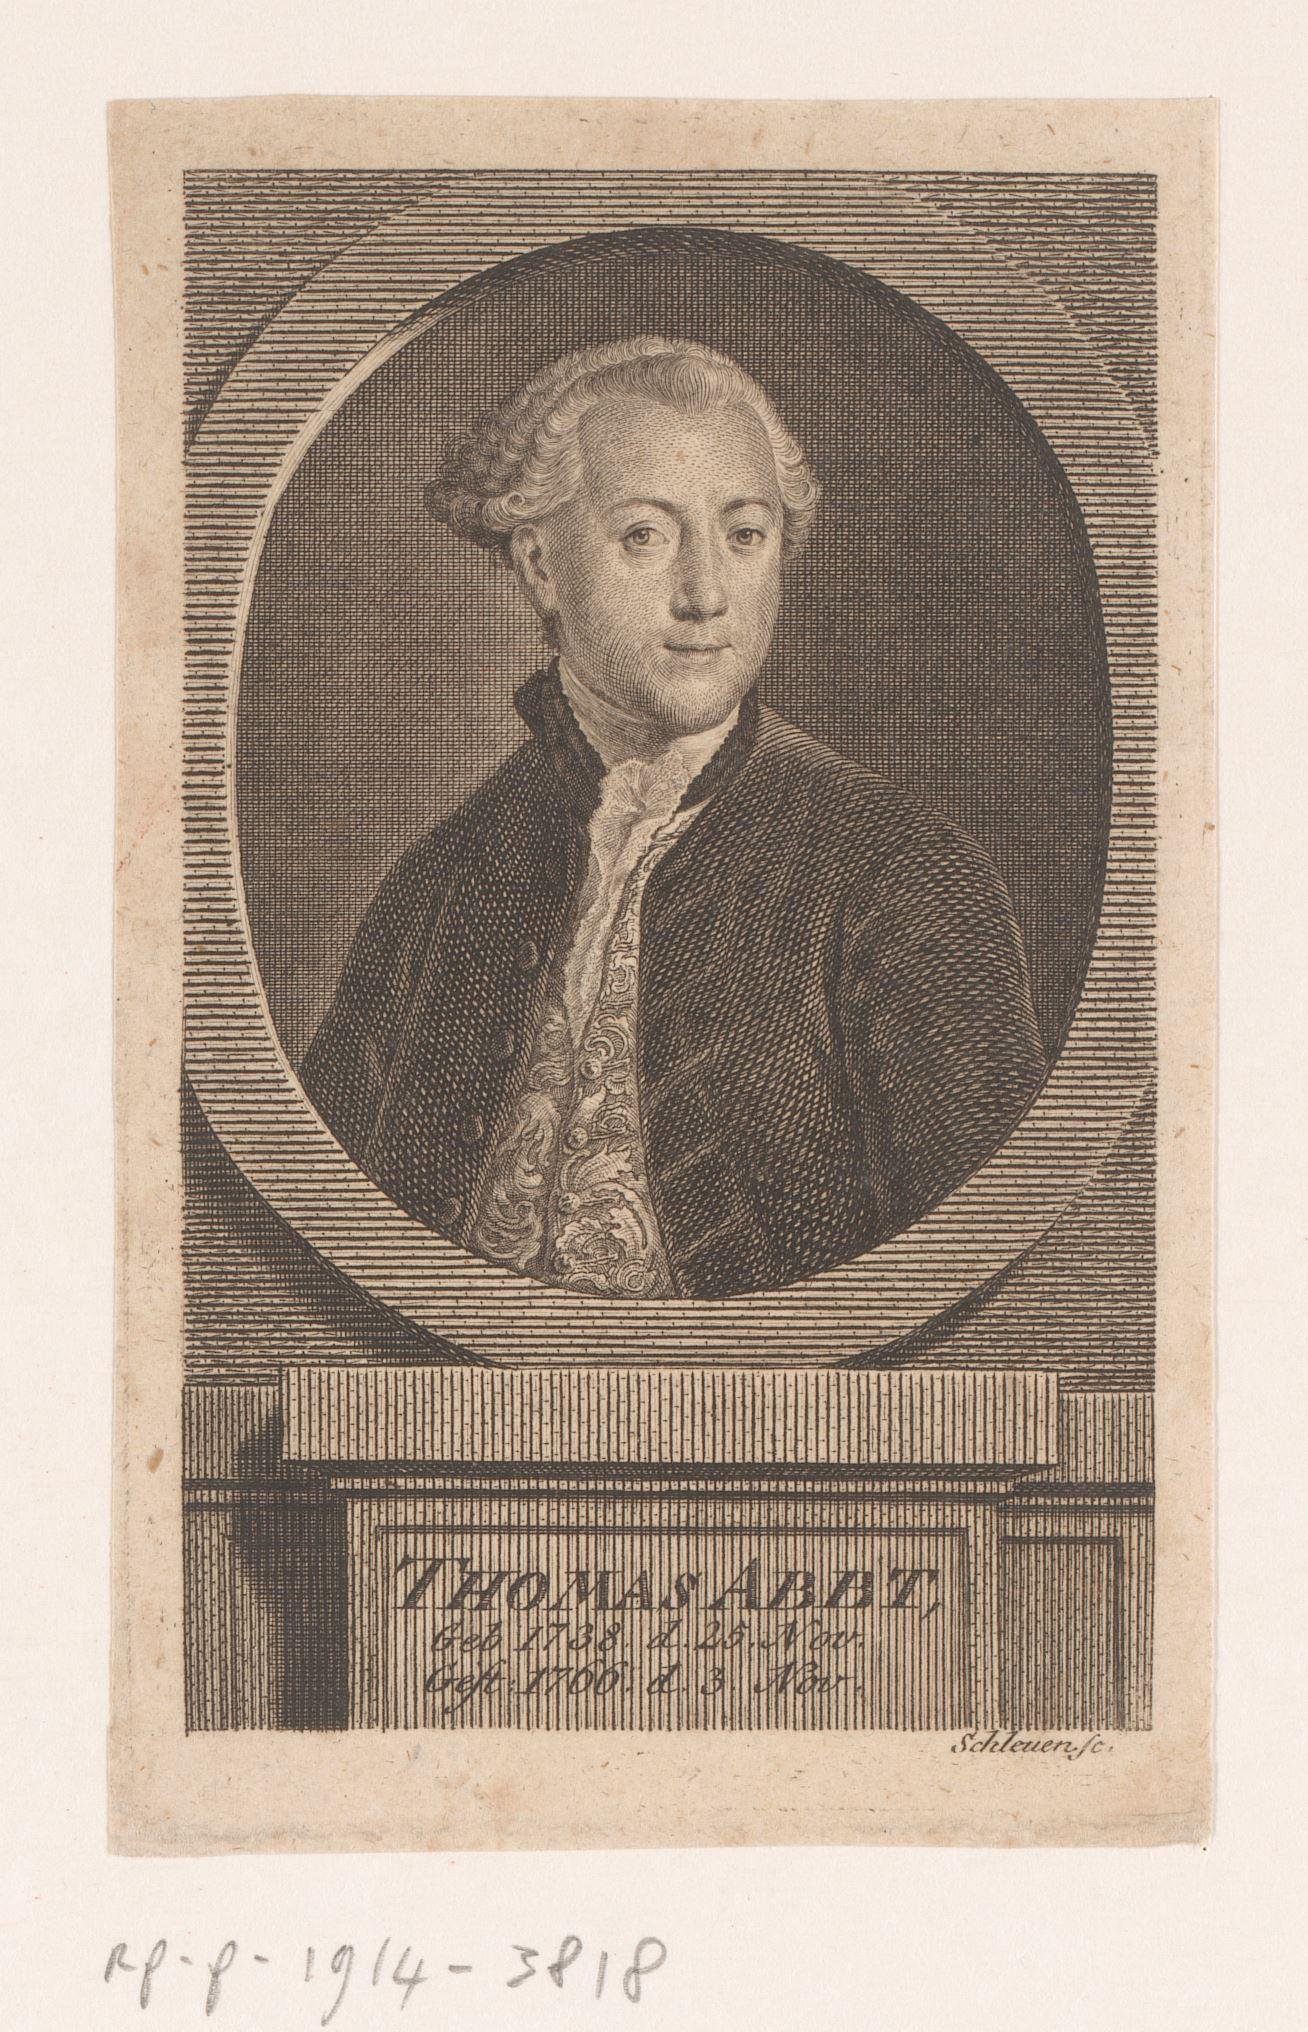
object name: print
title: Thomas Abbt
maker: johann david schleuen (i)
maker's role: print maker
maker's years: 1711-1774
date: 1766-1771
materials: paper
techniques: engraving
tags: historical persons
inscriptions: collector's mark: Lugt 2228